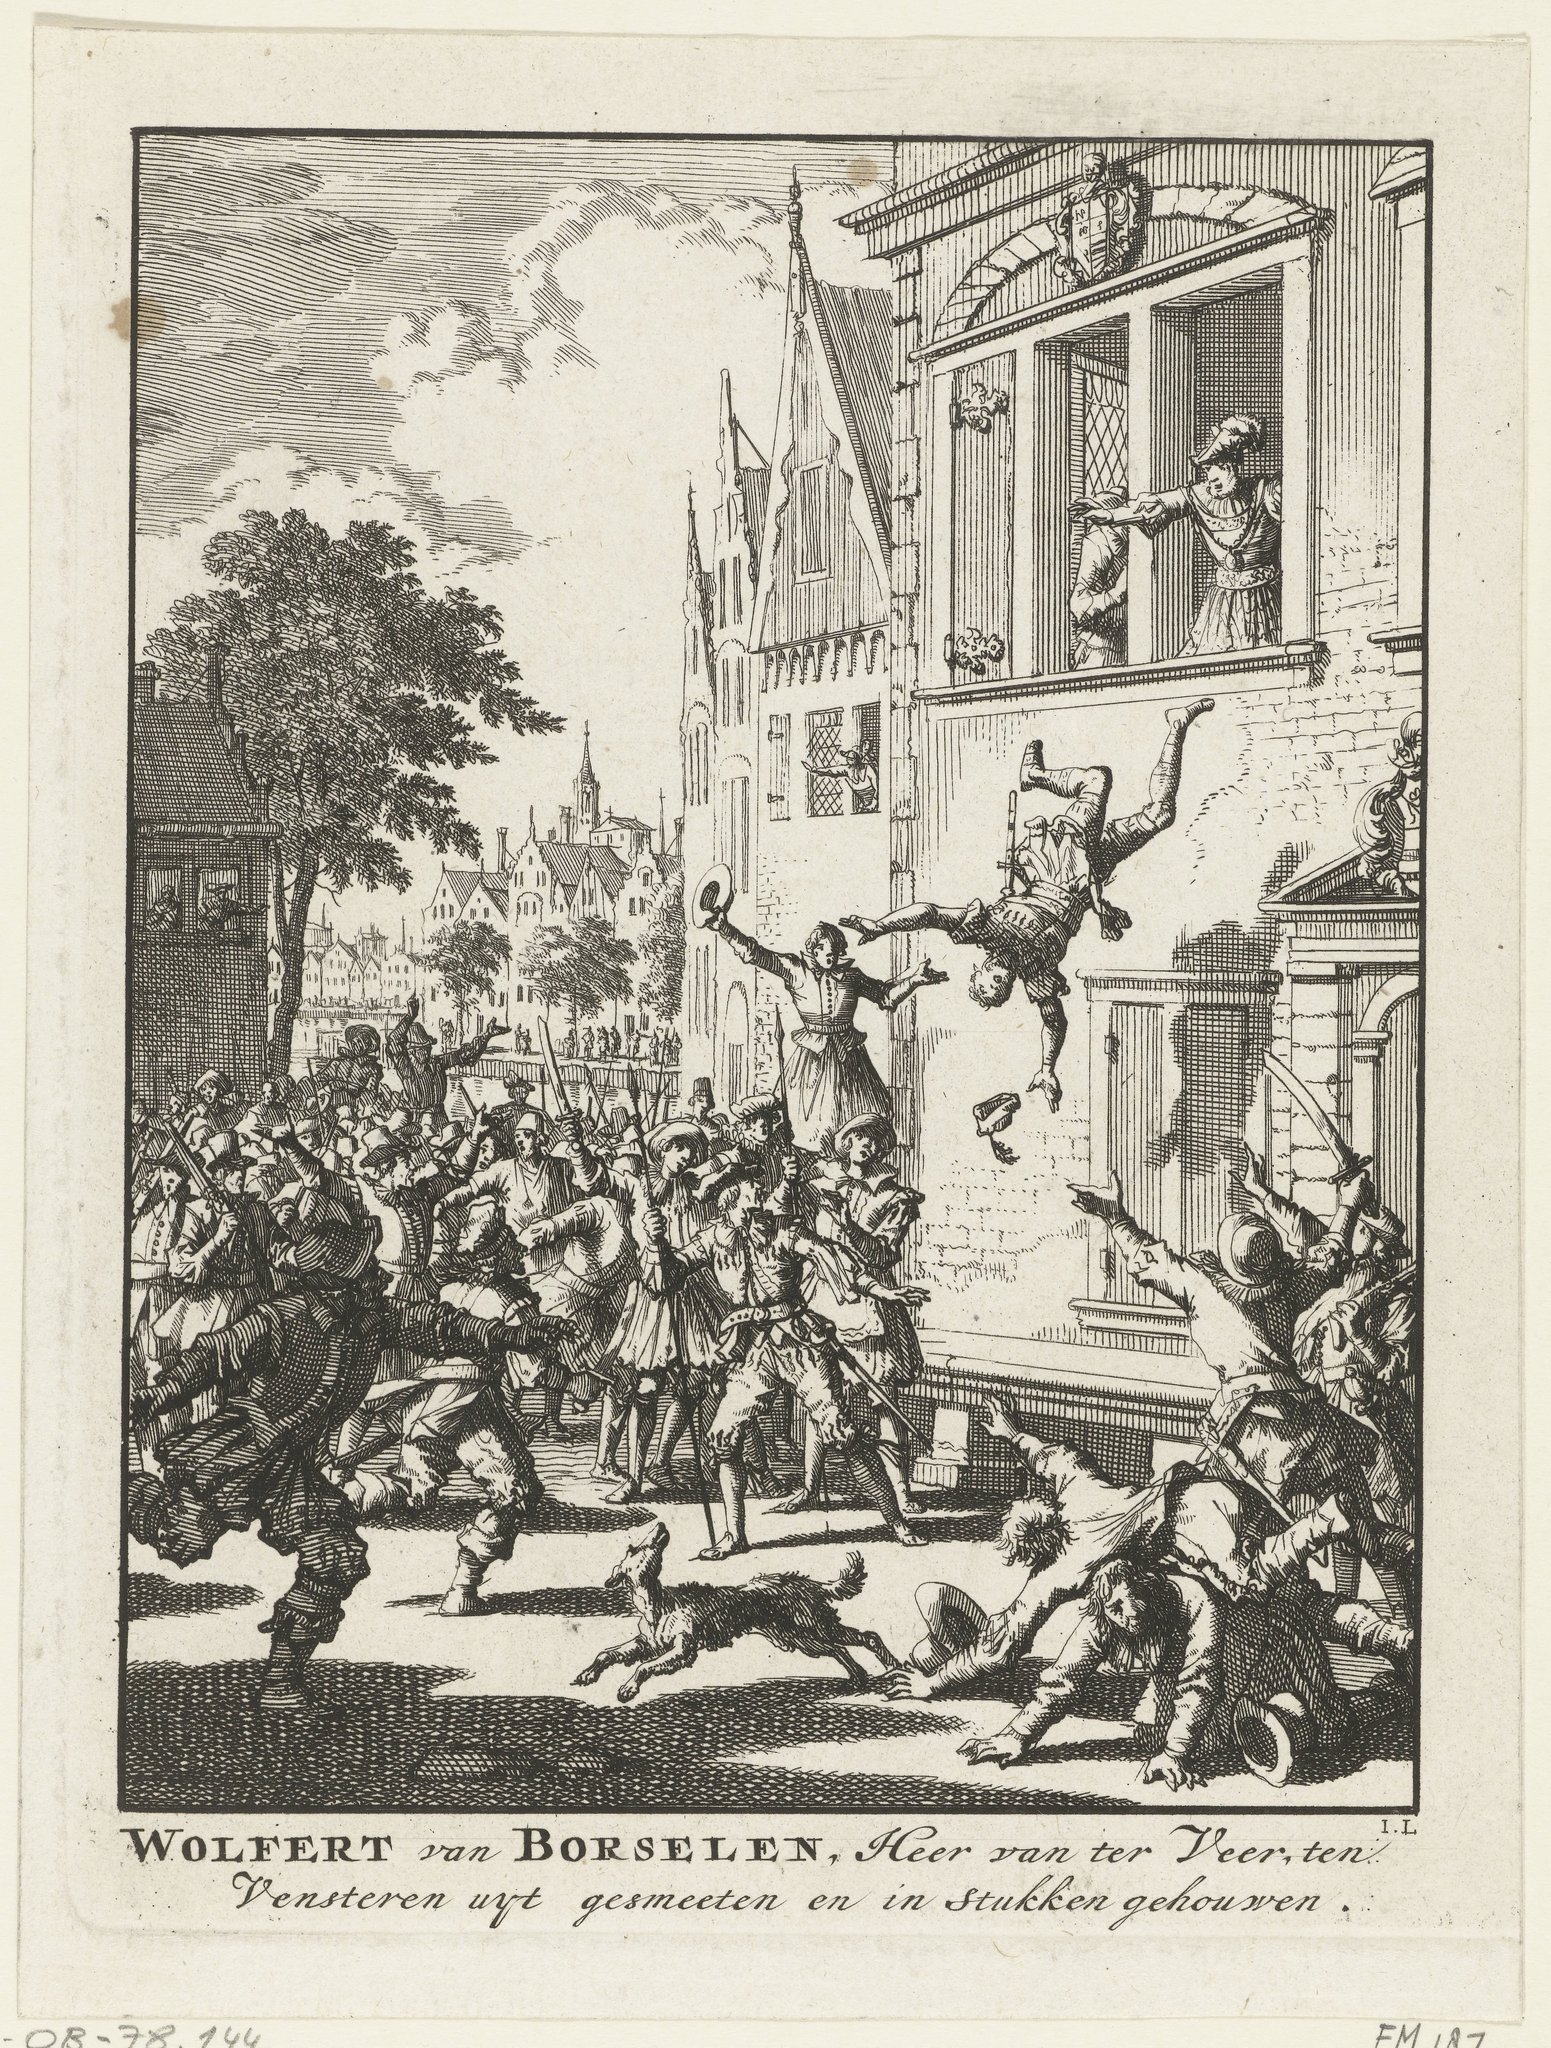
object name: print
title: Wolfert van Borselen te Delft uit het venster geworpen en vermoord, 1299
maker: jan luyken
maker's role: draughtsman, print maker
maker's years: 1649-1712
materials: paper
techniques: engraving, etching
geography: amsterdam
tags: lynching, delft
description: Eerdere staat van prent ook gebruikt in: Bosch, Lambert van den. Treur-toonneel der doorluchtige mannen, of op- en ondergang der grooten, vertoont in de rampzalige geschiedenissen van […]. 3 delen. Amsterdam: Jan Claesz ten Hoorn, 1698, dl. 1, afd. 2, tussen p. 200 en 201.